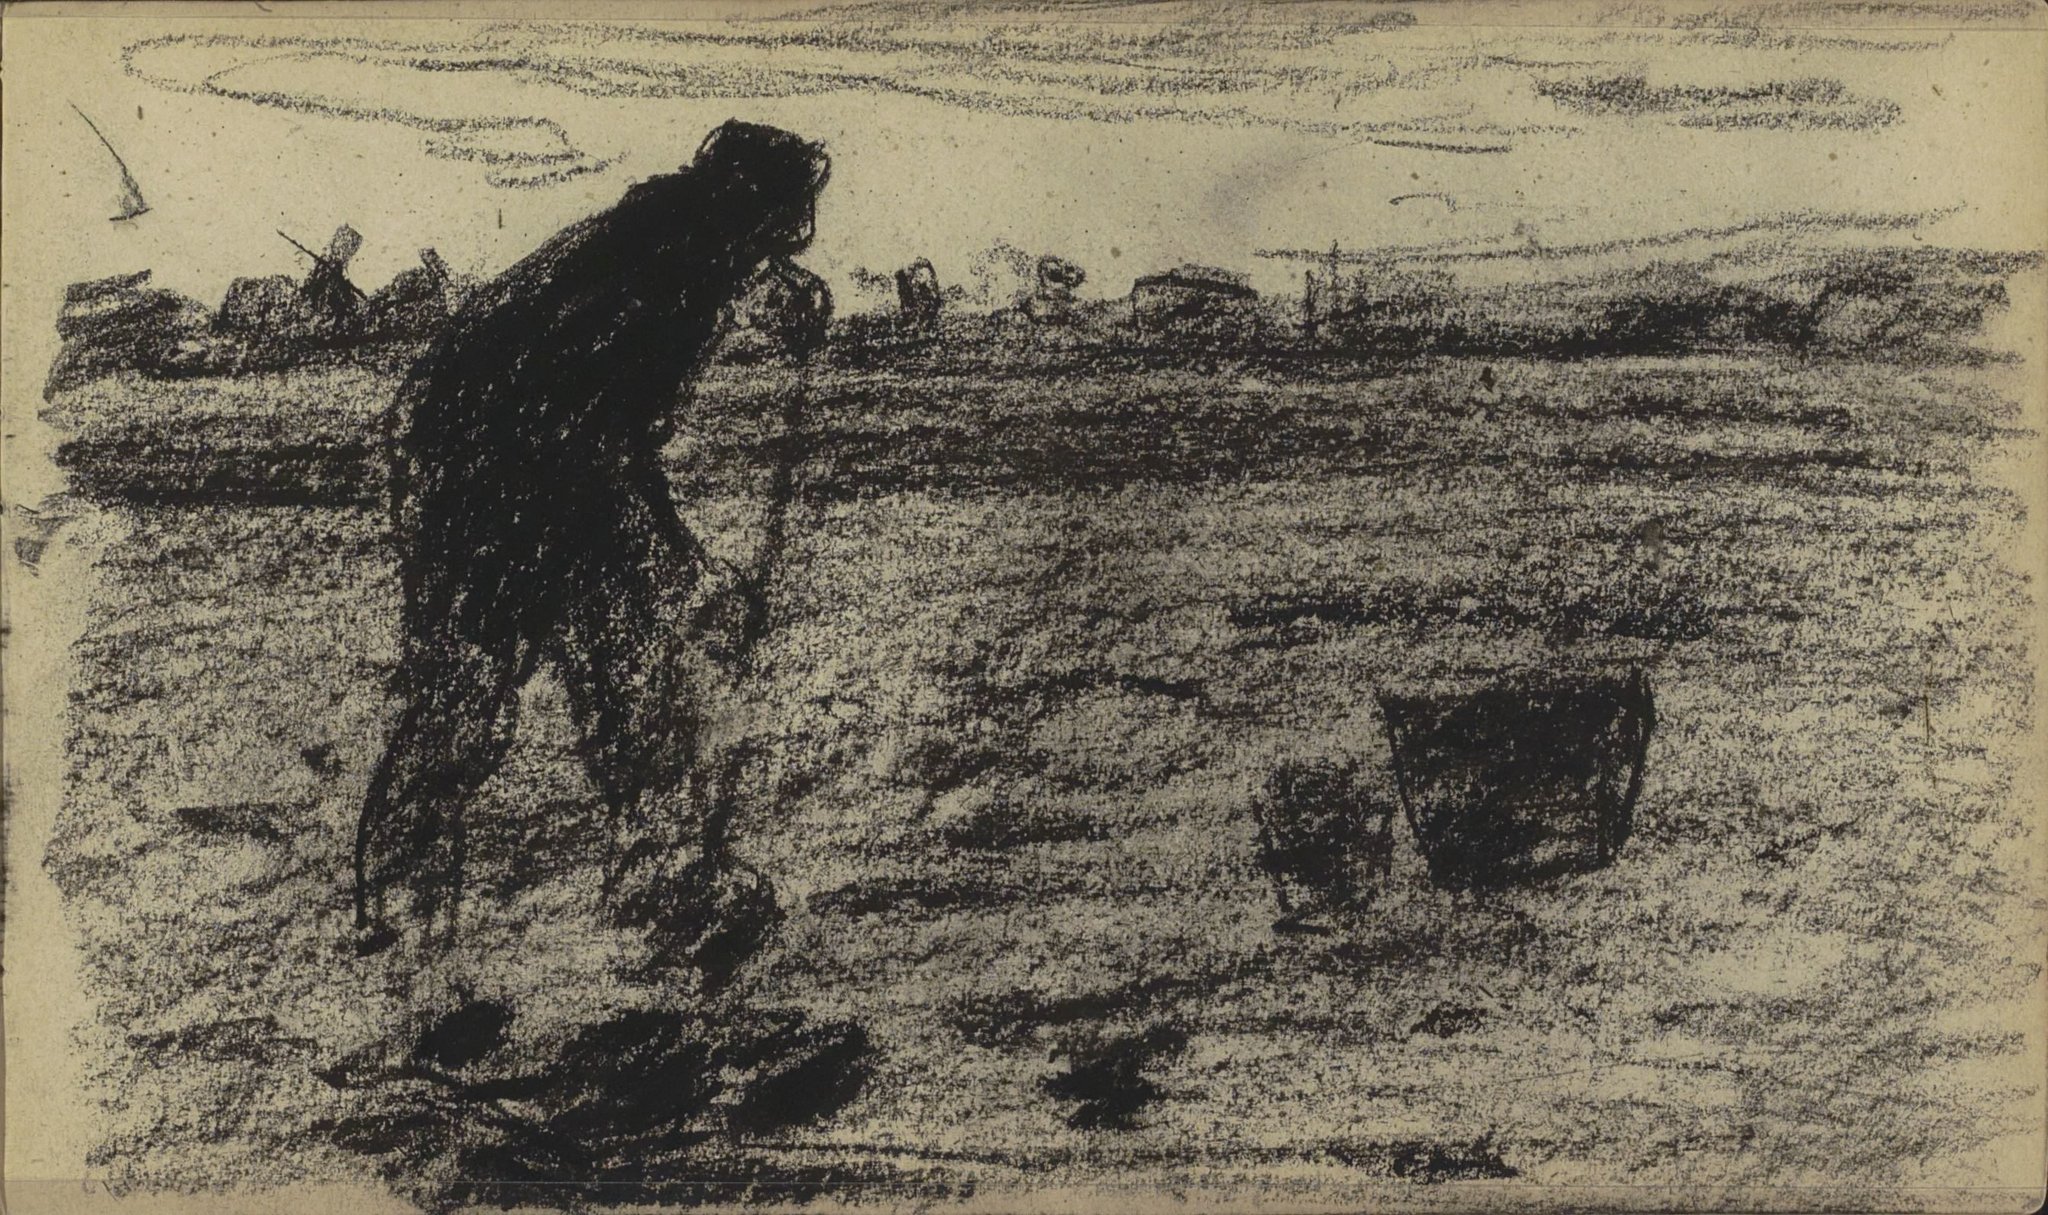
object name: sketchbook leaf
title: Man op het land, mogelijk een aardappelrooier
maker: willem witsen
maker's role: draughtsman, painter, print maker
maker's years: 1860-1923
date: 1888-1897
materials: chalk, paper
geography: ewijkshoeve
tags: reaping, picking, mowing ~ harvest (+ men (labourers)), prospect of village, silhouette of village, cultivated land (+ landscape with figures, staffage)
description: In de verte een dorpsgezicht. Pagina 41 uit een schetsboek met 25 bladen.